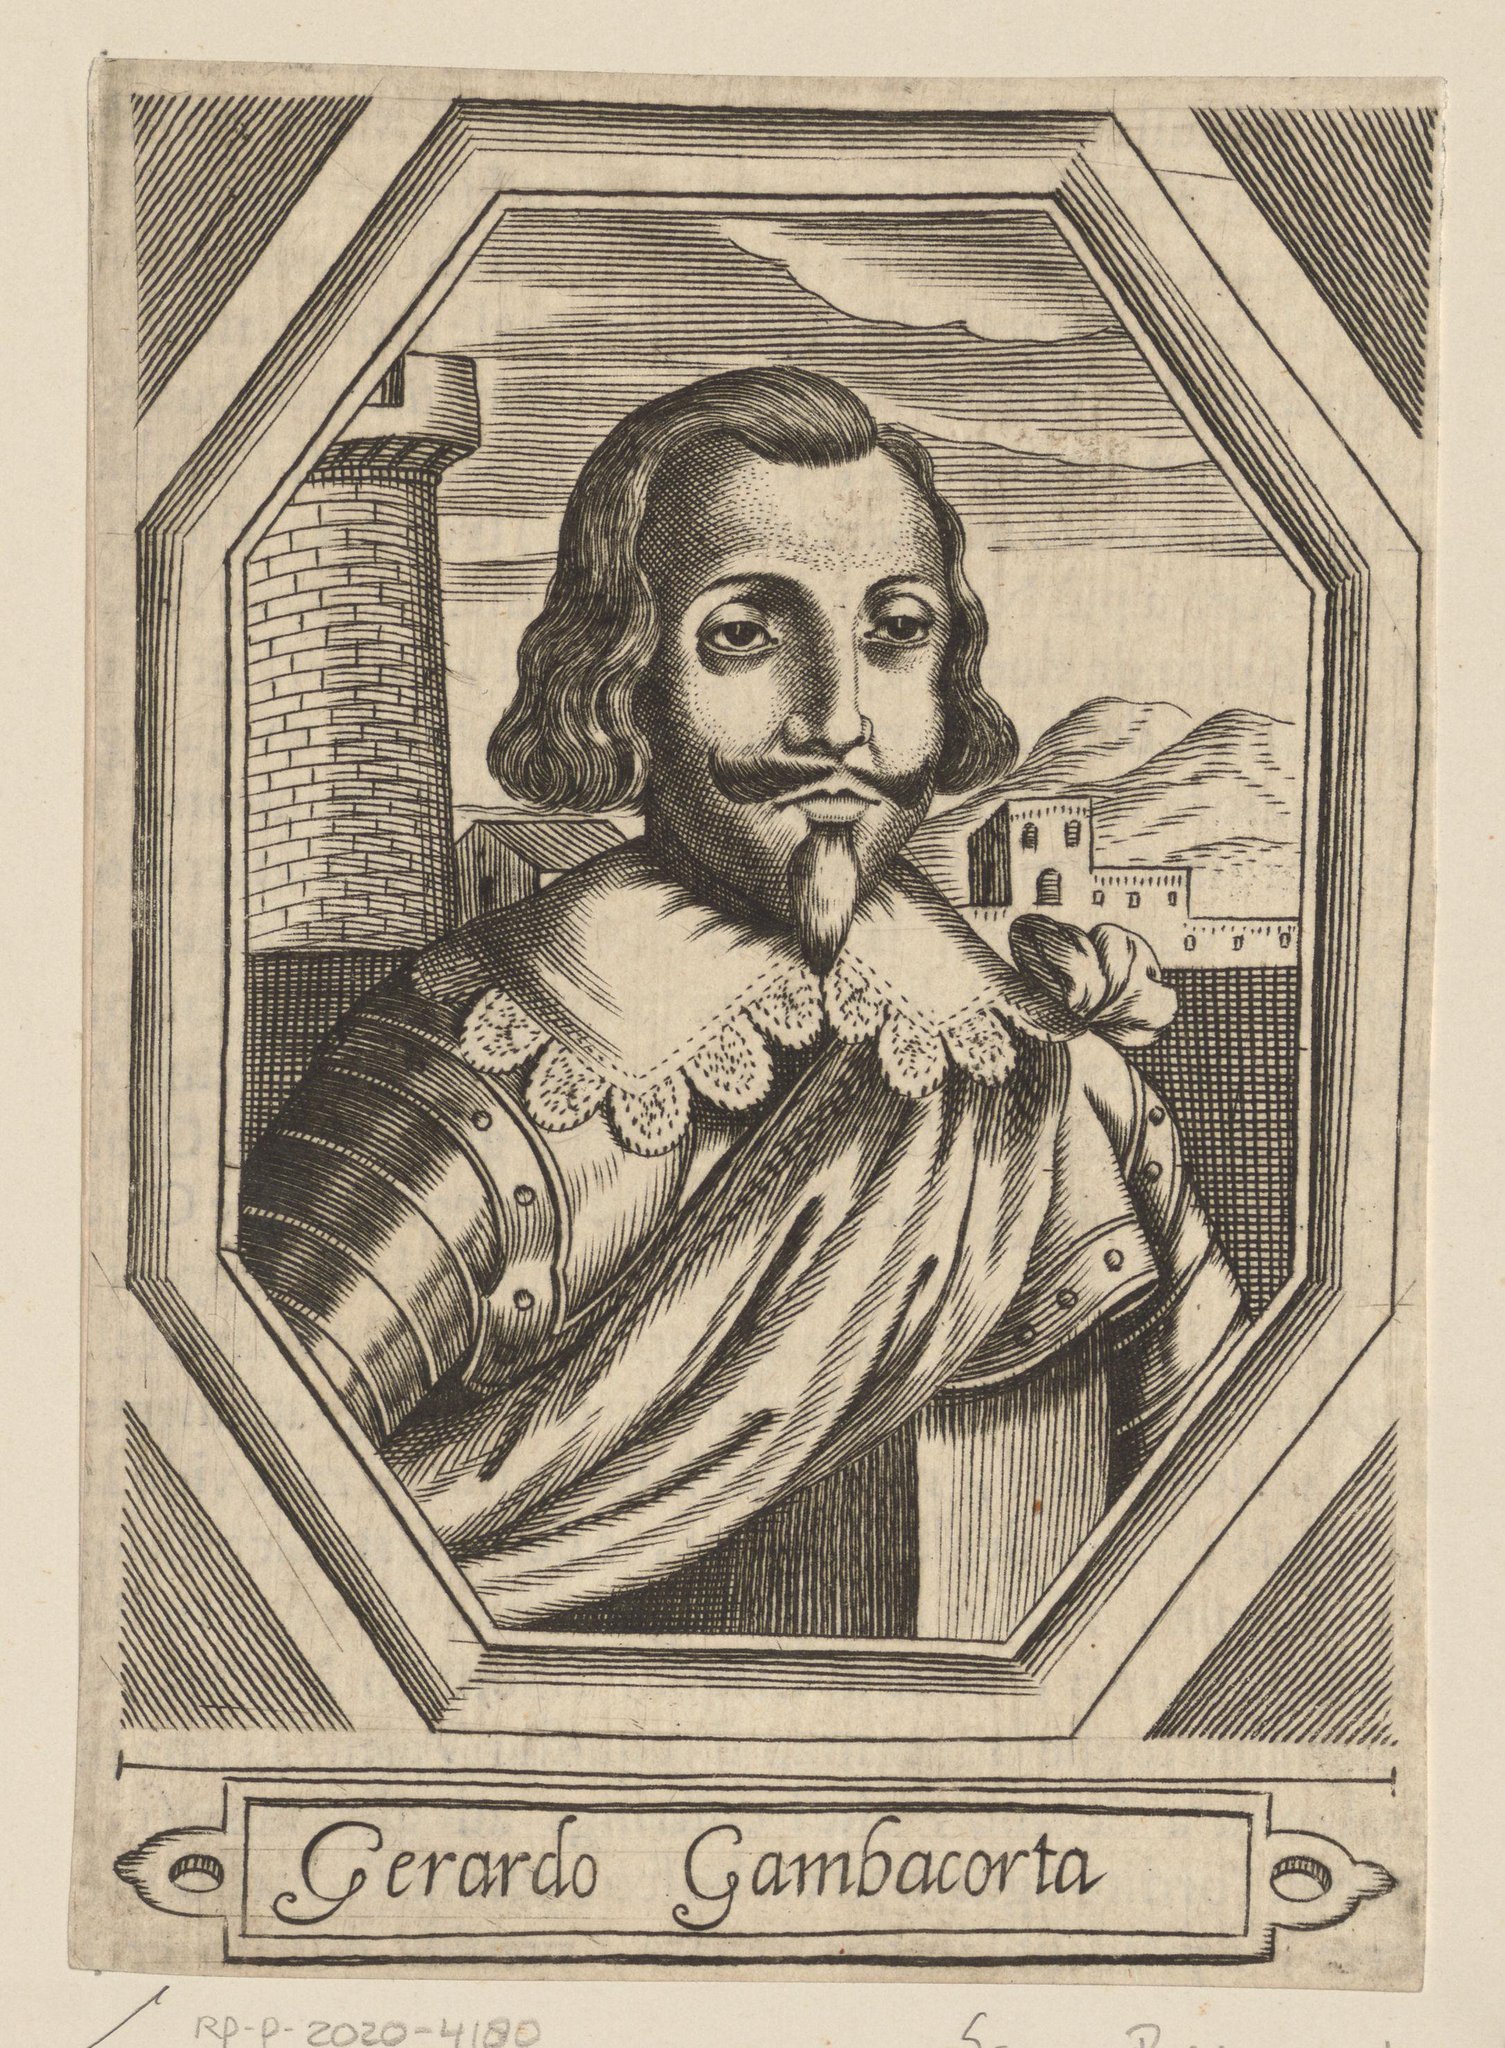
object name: print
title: Portret van Gerardo Gambacorta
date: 1683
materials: paper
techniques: engraving, etching, letterpress printing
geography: venice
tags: historical persons, officer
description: Prent uit: Crasso, Lorenzo. Elogii di capitani illustri. Venetië: Sebastiano Combi en Giovanni la Noù, 1683, p. 231.